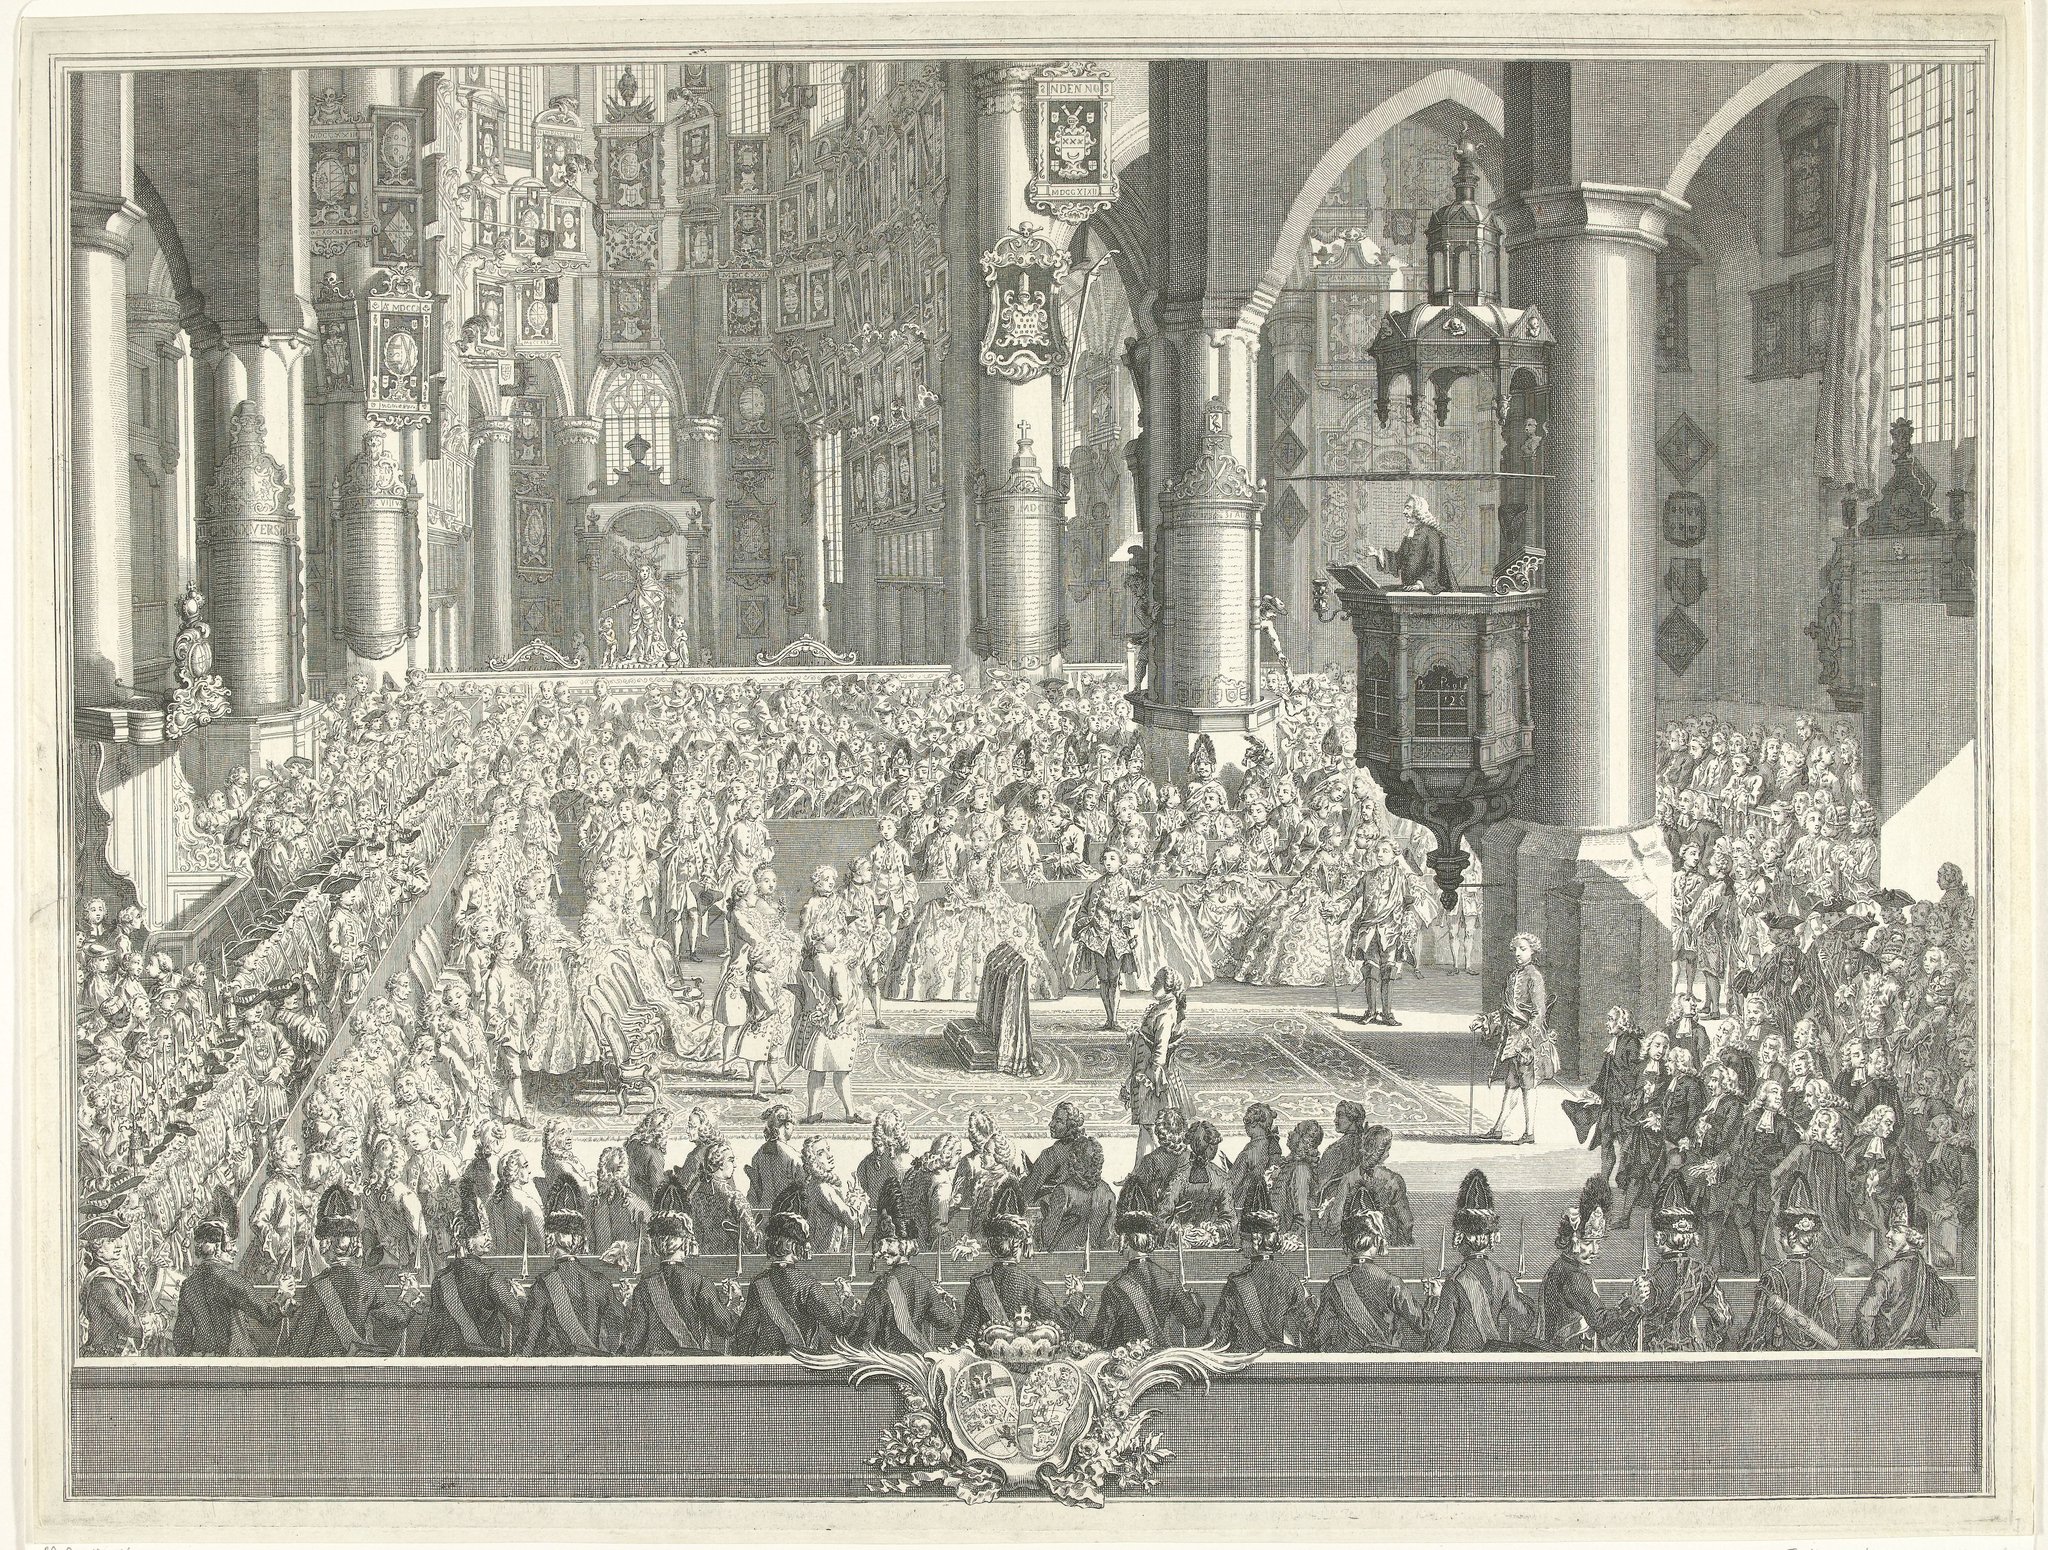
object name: print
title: Huwelijk van Karel Christiaan van Nassau-Weilburg en Carolina, prinses van Oranje-Nassau, 1760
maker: simon fokke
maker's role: draughtsman, print maker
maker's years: 1712-1784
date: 1759-1761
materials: paper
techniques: etching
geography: amsterdam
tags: carolina (prinses van oranje-nassau), karel christiaan vorst van nassau-weilburg, marriage ~ protestant service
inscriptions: collector's mark: Lugt 2228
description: Trouwplechtigheid van Karel Christiaan van Nassau-Weilburg en Carolina, prinses van Oranje-Nassau in de Grote Kerk te Den Haag op 5 maart 1760.